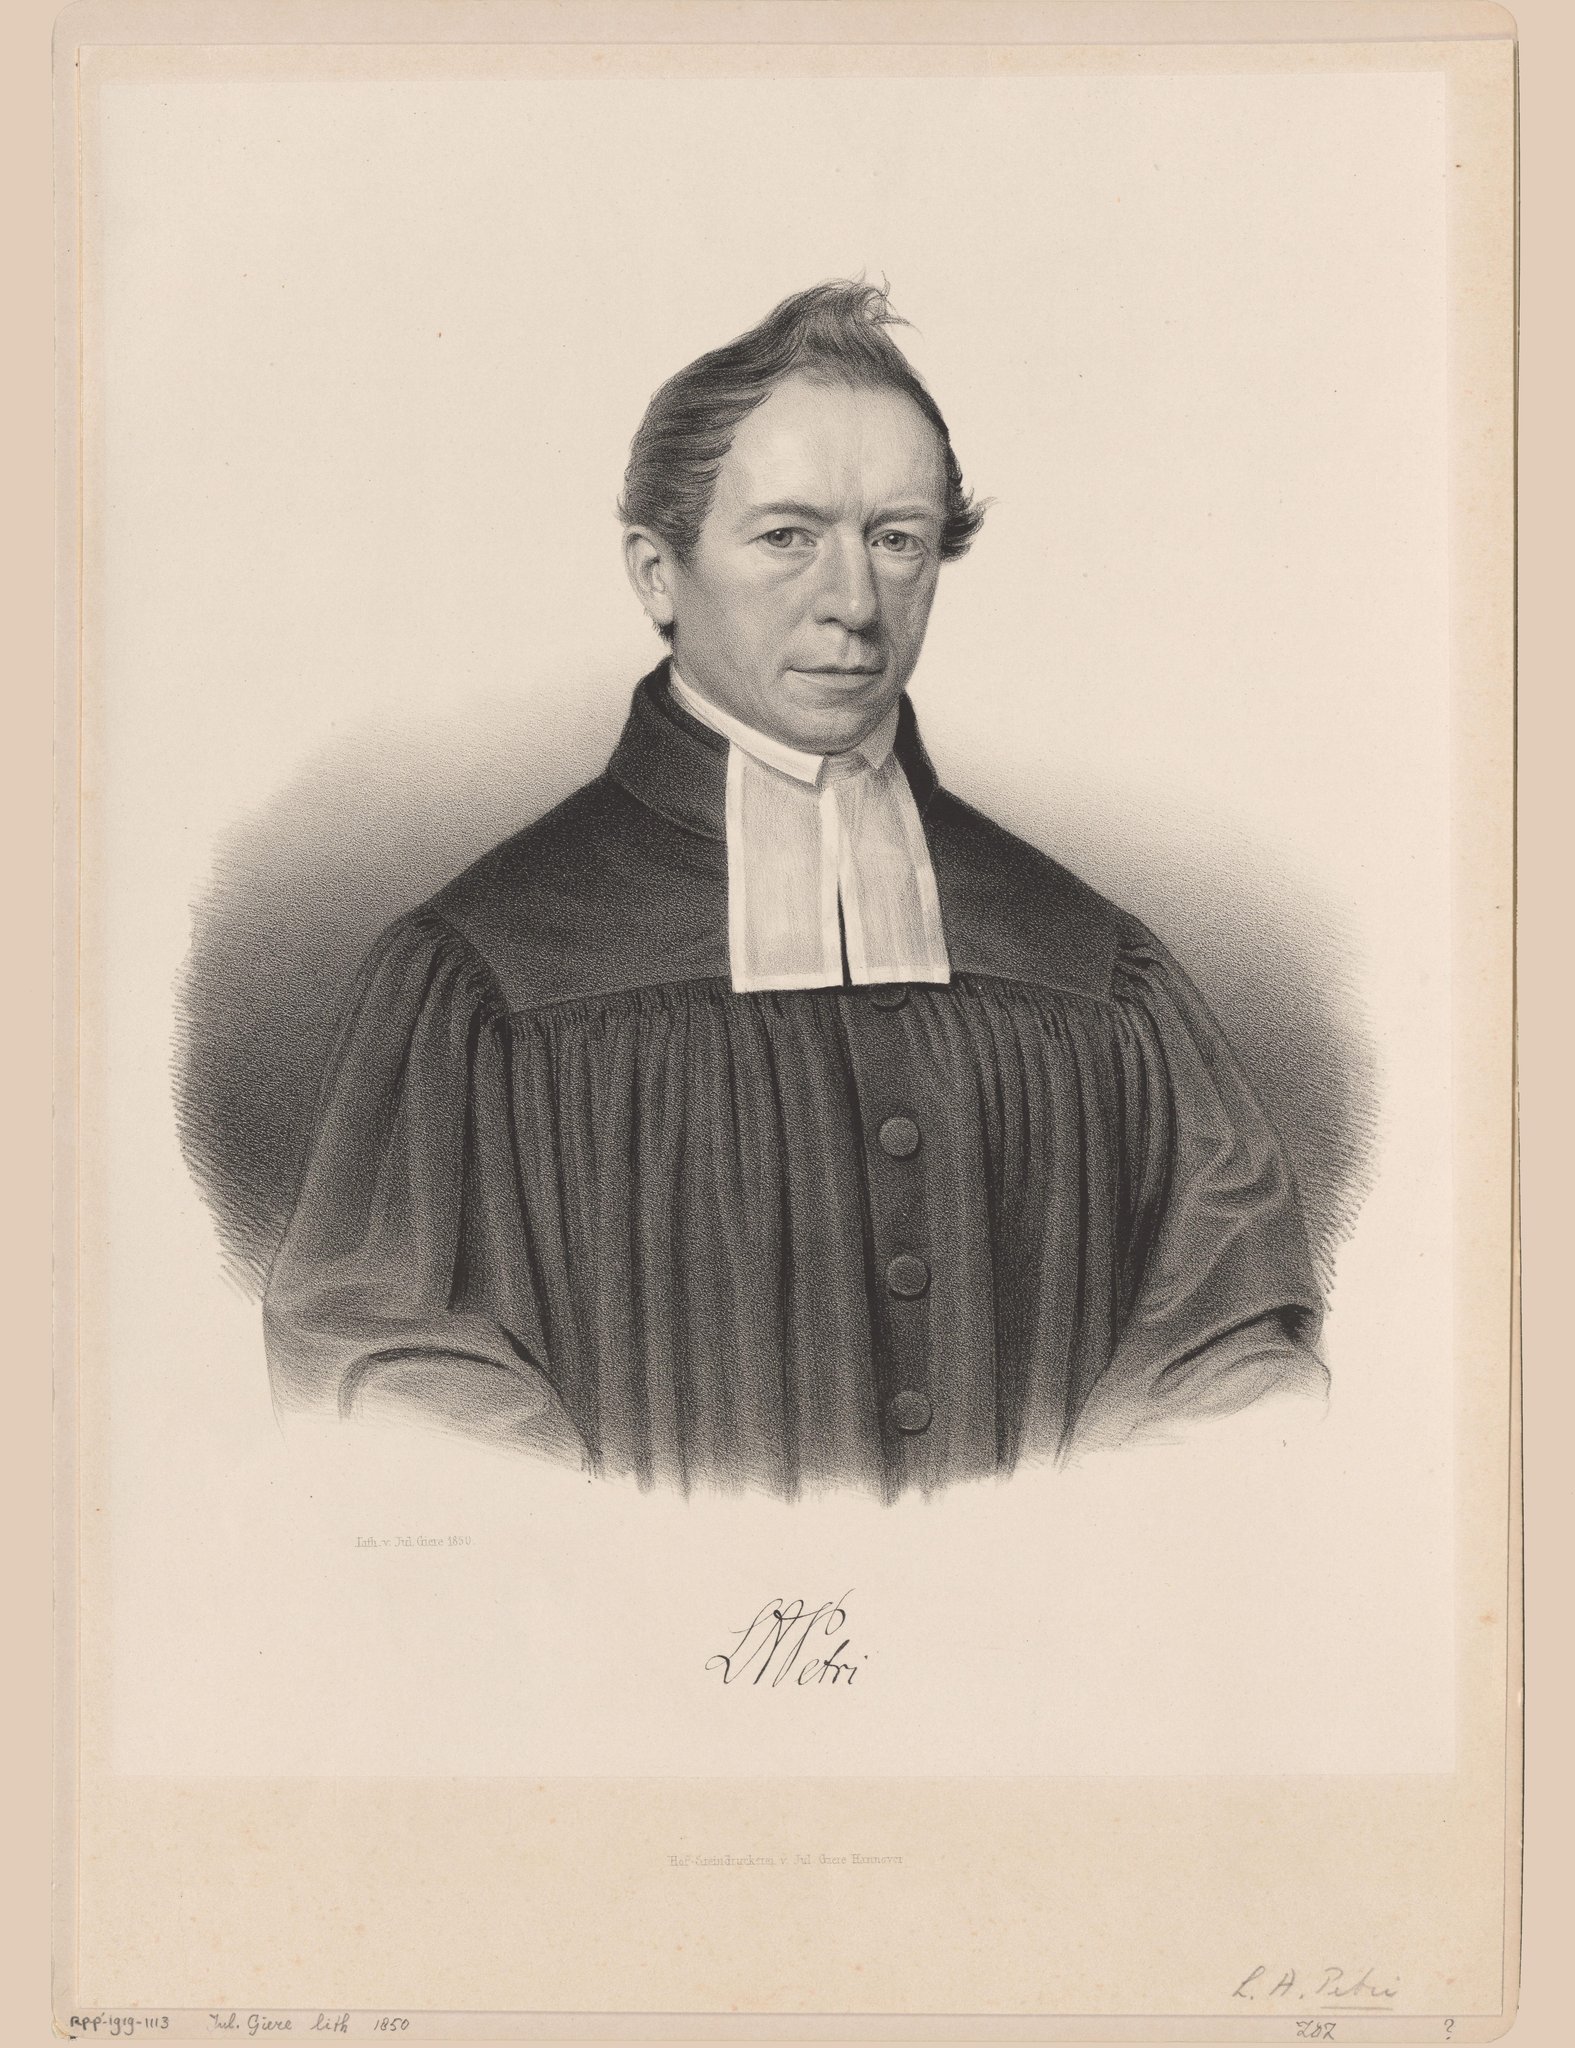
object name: print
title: Portret van Ludwig Adolf Petri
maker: julius giere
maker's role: print maker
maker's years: 1807-1880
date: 1850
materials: paper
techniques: lithograph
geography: hannover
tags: clergyman, adult man, historical persons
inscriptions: collector's mark: Lugt 2228